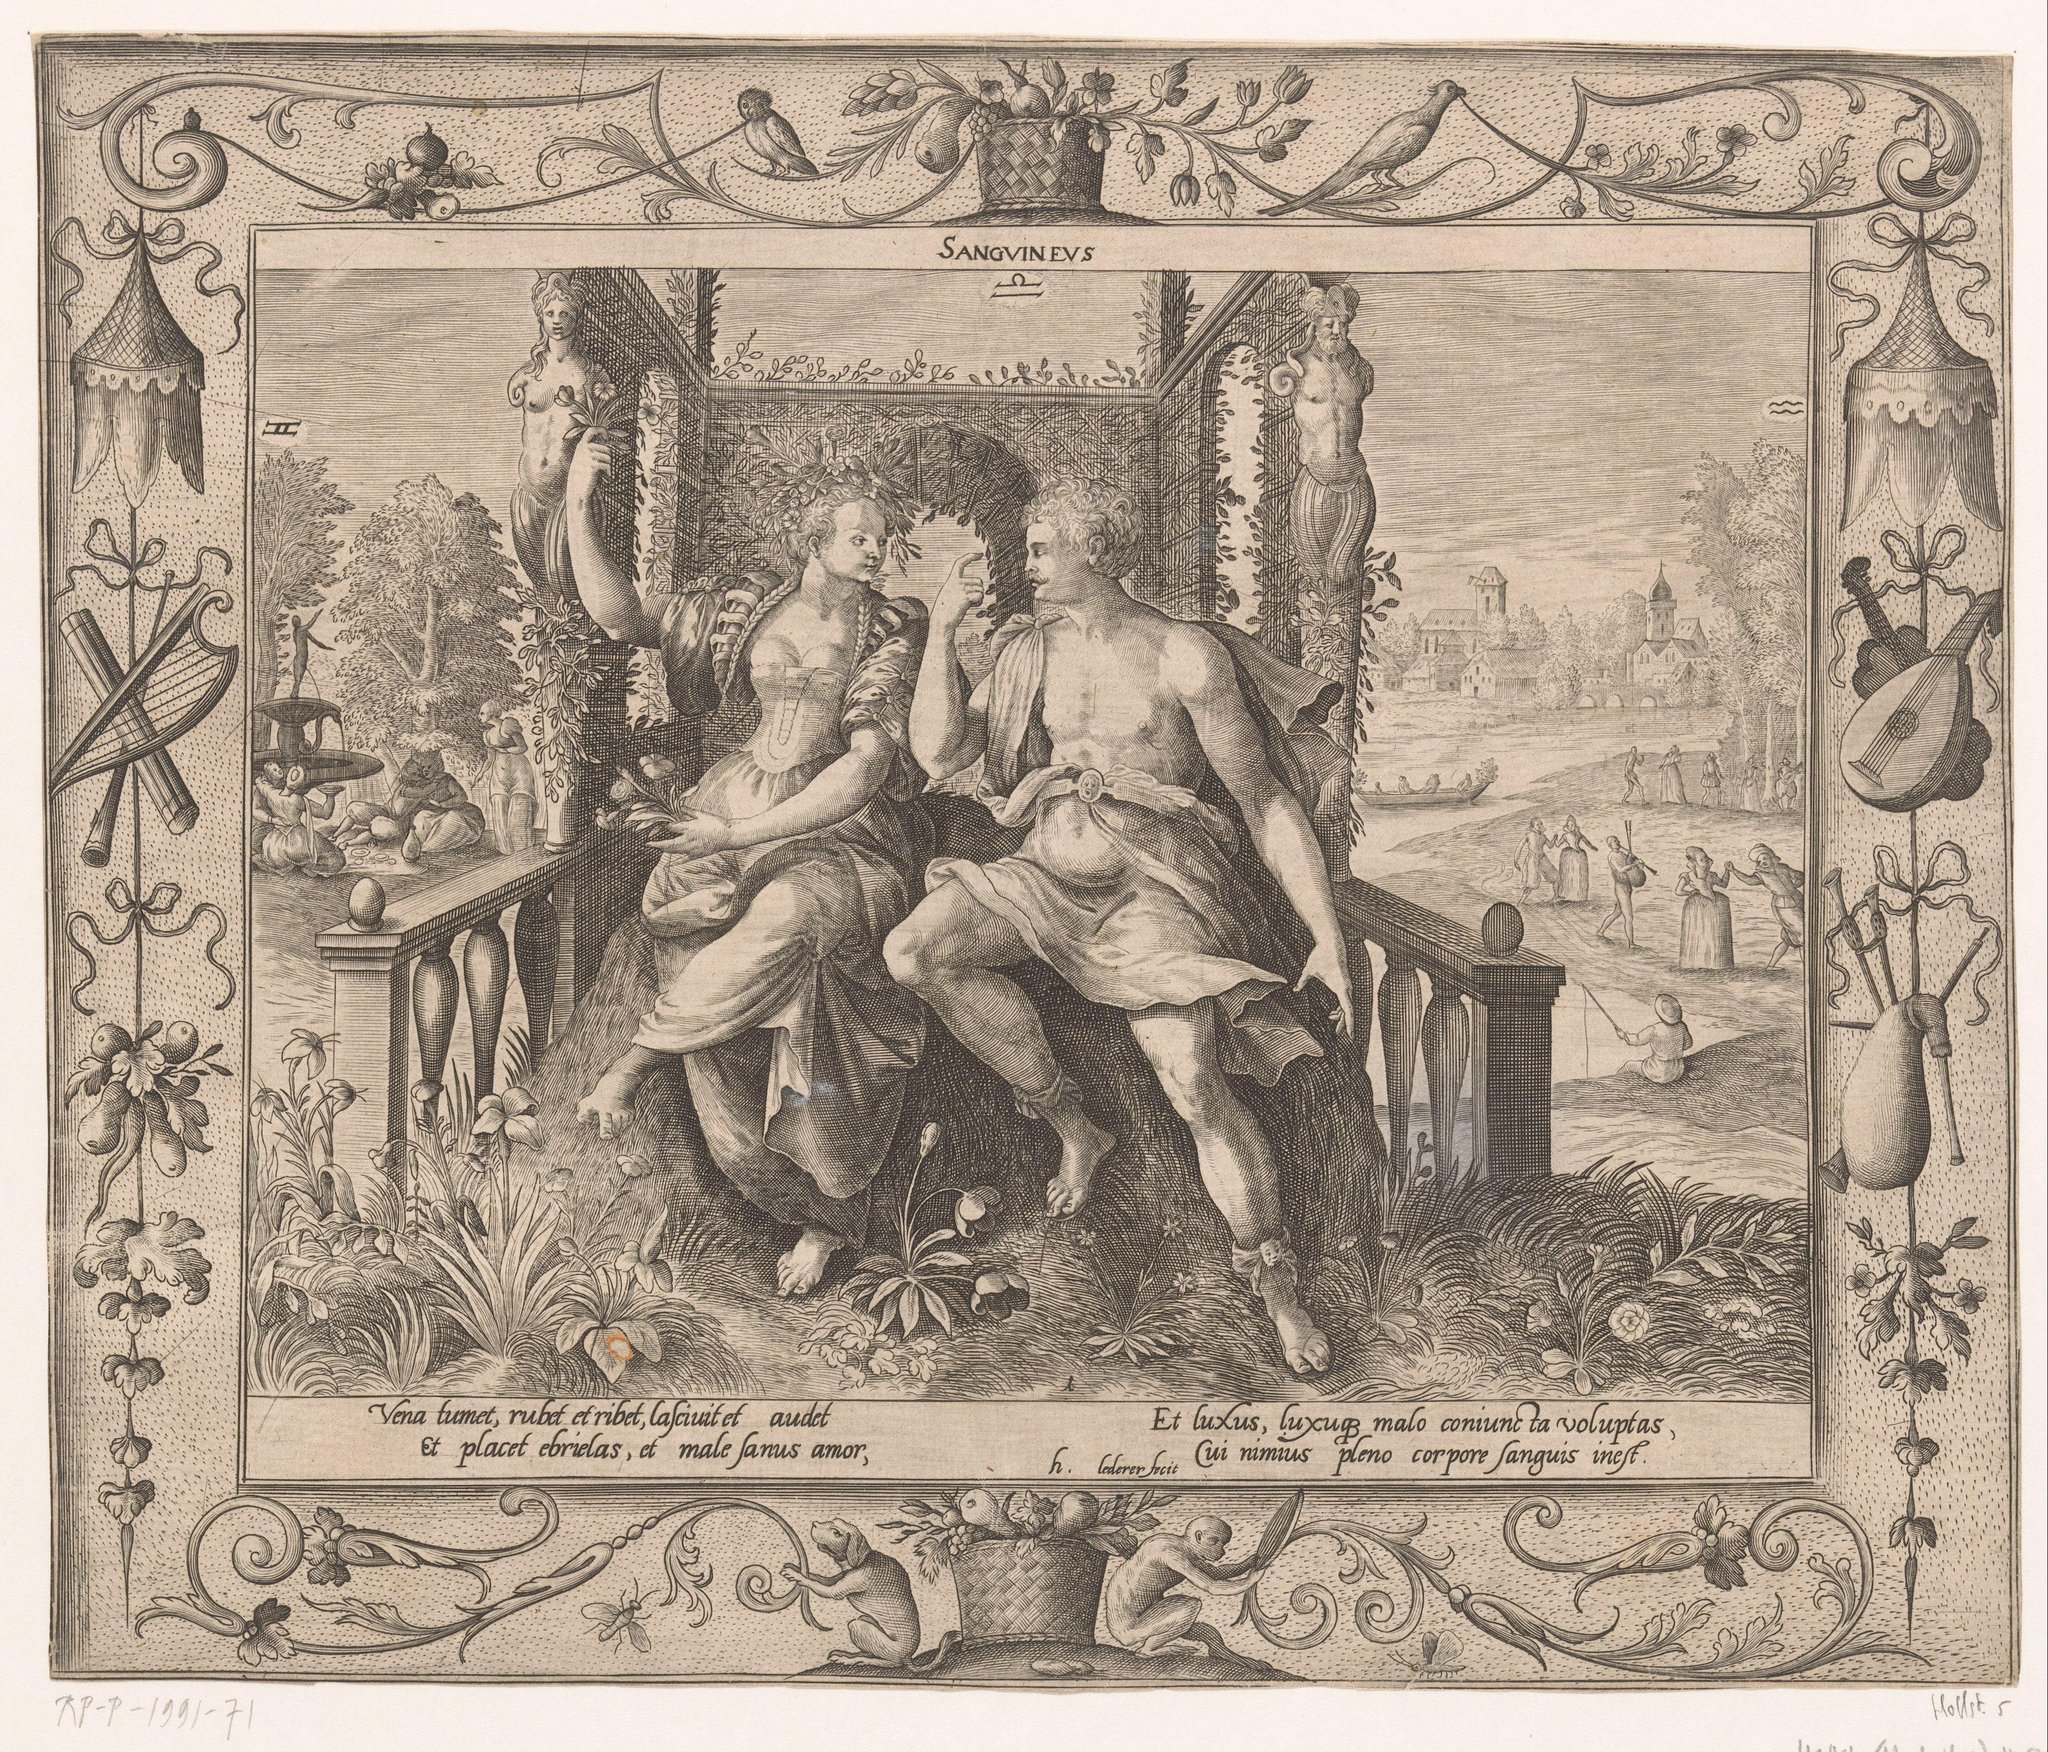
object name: print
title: Sanguinisch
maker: hieronymus lederer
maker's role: print maker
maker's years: -1615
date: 1600-1615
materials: paper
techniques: engraving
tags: sanguine temperament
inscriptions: collector's mark: Lugt 2228, collector's mark, collector's mark: Lugt 2760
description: Kopie in dezelfde richting met toegevoegde ornamentele rand naar prent van Raphaël Sadeler (I), naar ontwerp van Maarten de Vos uit 1583.